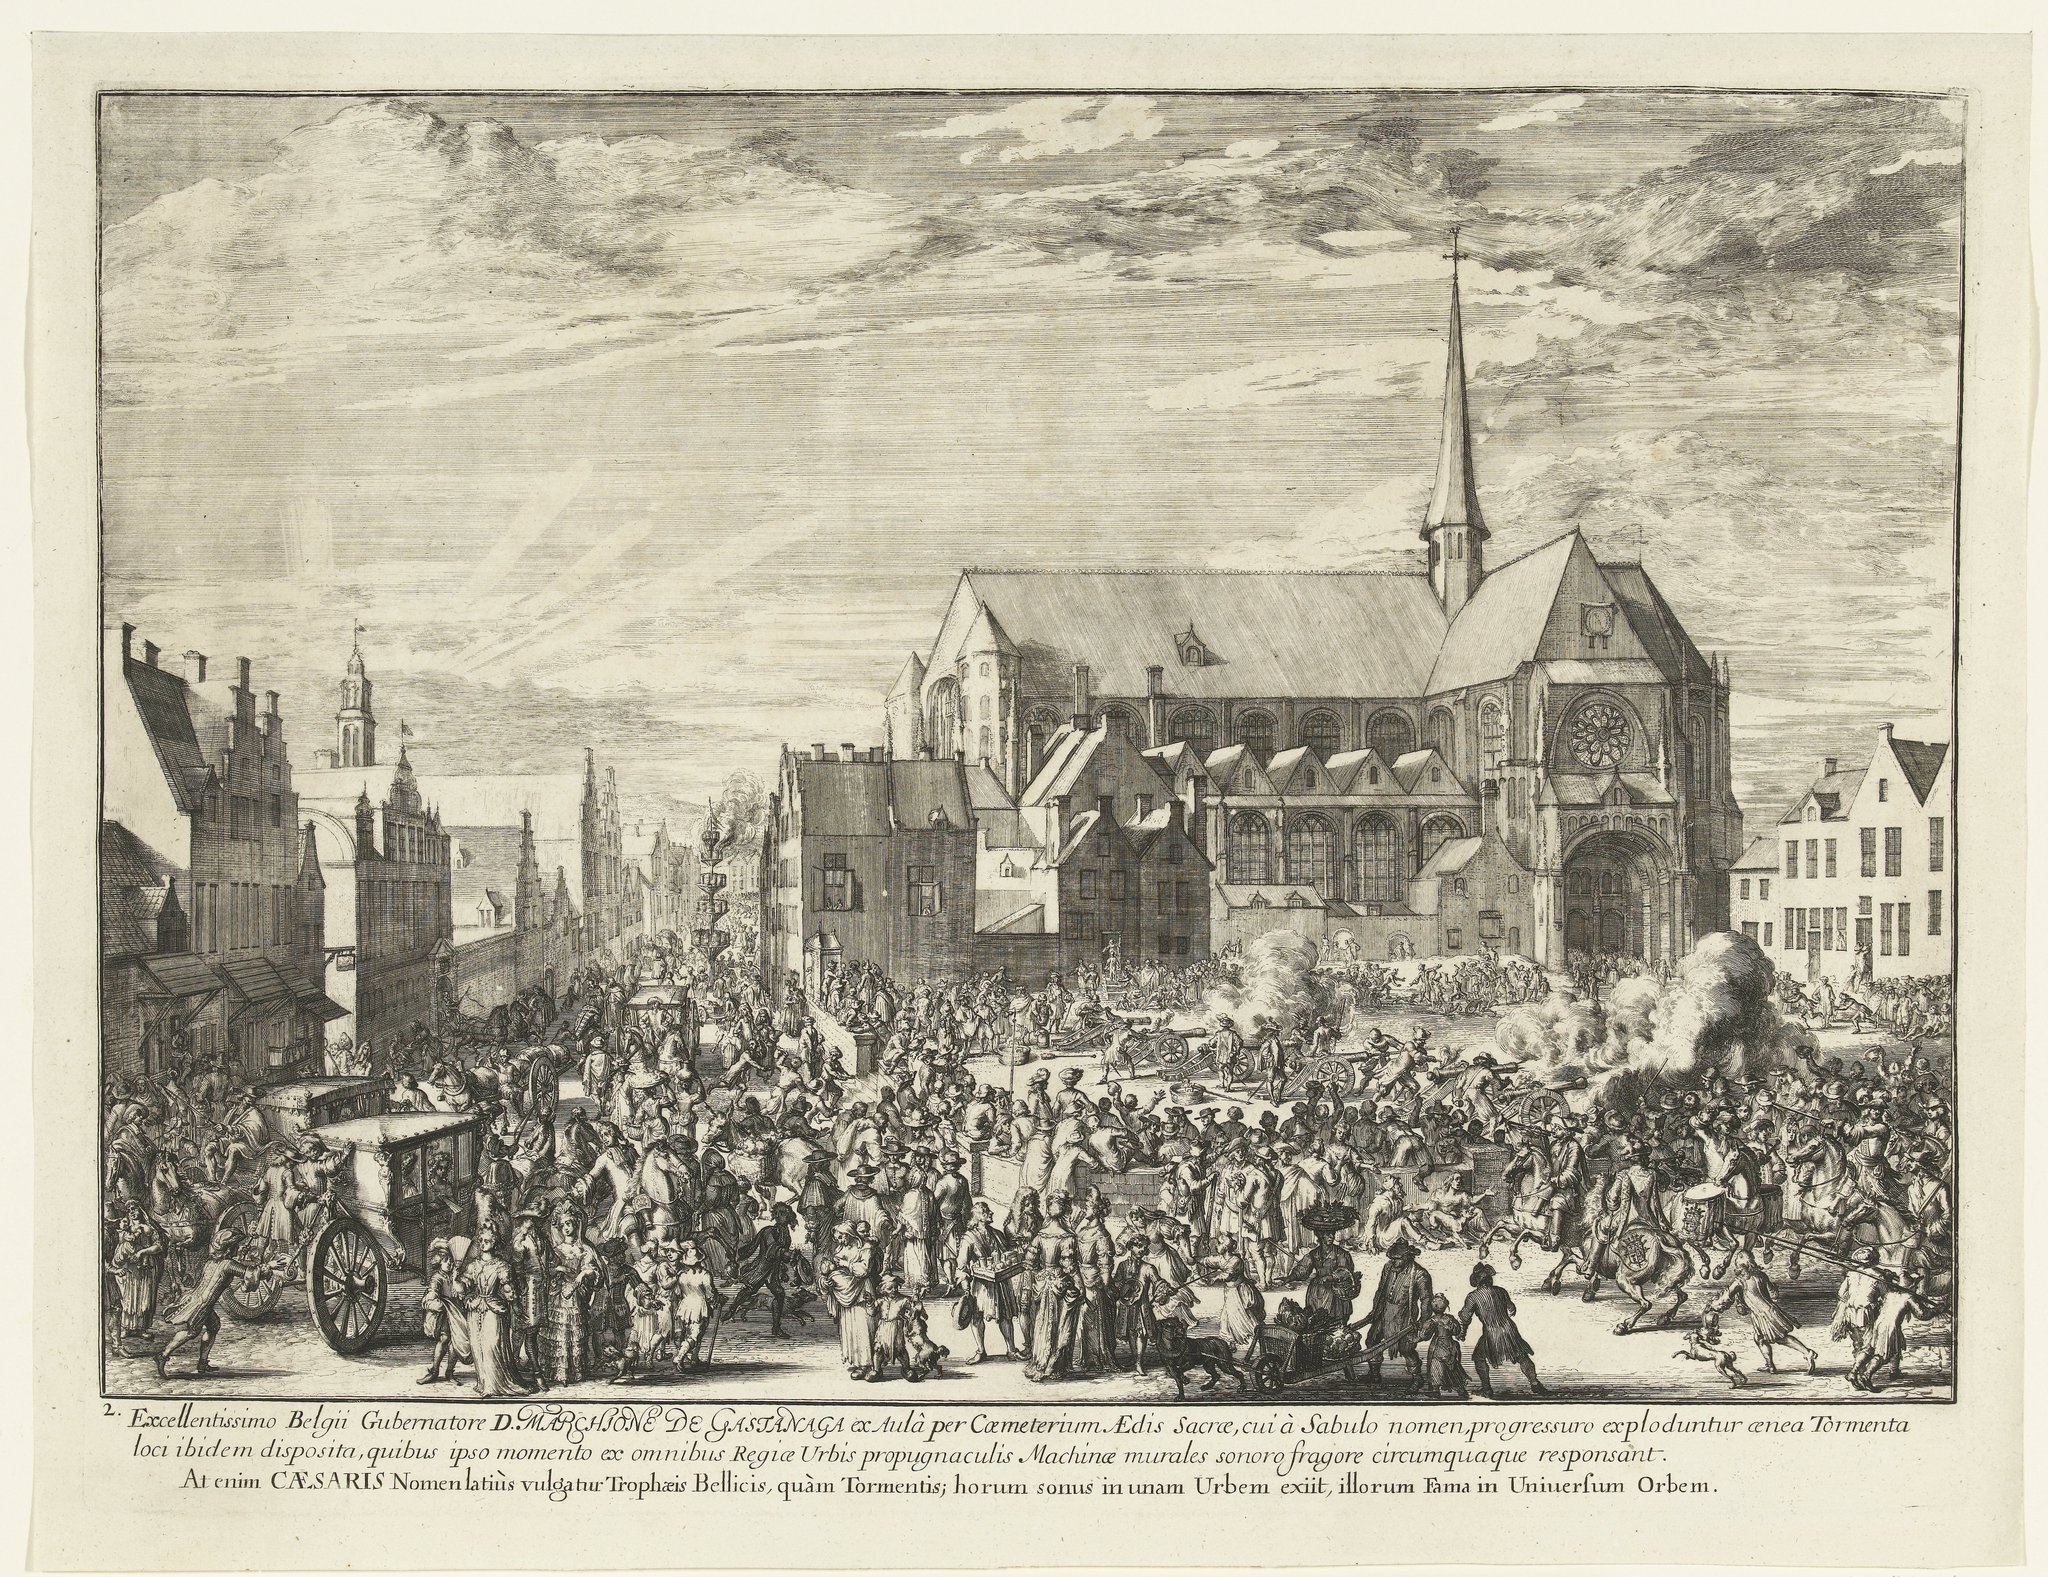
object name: print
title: Intocht van Leopold I in Brussel na het verslaan van de Turken, 1686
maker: romeyn de hooghe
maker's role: draughtsman, goldsmith, painter, print maker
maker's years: 1645-1708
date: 1686-1687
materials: paper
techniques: etching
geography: haarlem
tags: francisco antonio de agurto (markies van gastañaga), leopold i (keizer van duitsland), crowd, mob, triumphal entry and public reception, pageant, 'entrée solennelle', 'joyeuse entrée', festivities (+ illumination, fire-works ~ festive activities), cannon shots (military salute), brussels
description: Intocht van Leopold I in Brussel, 1686. Op een druk plein worden voor de Onze-Lieve-Vrouw ten Zavel ceremonieel kanonnen afgevuurd. Links op de voorgrond rijden koetsen en rechtsvoor komen ruiters aangereden. Links op de achtergrond wordt vuurwerk afgestoken.